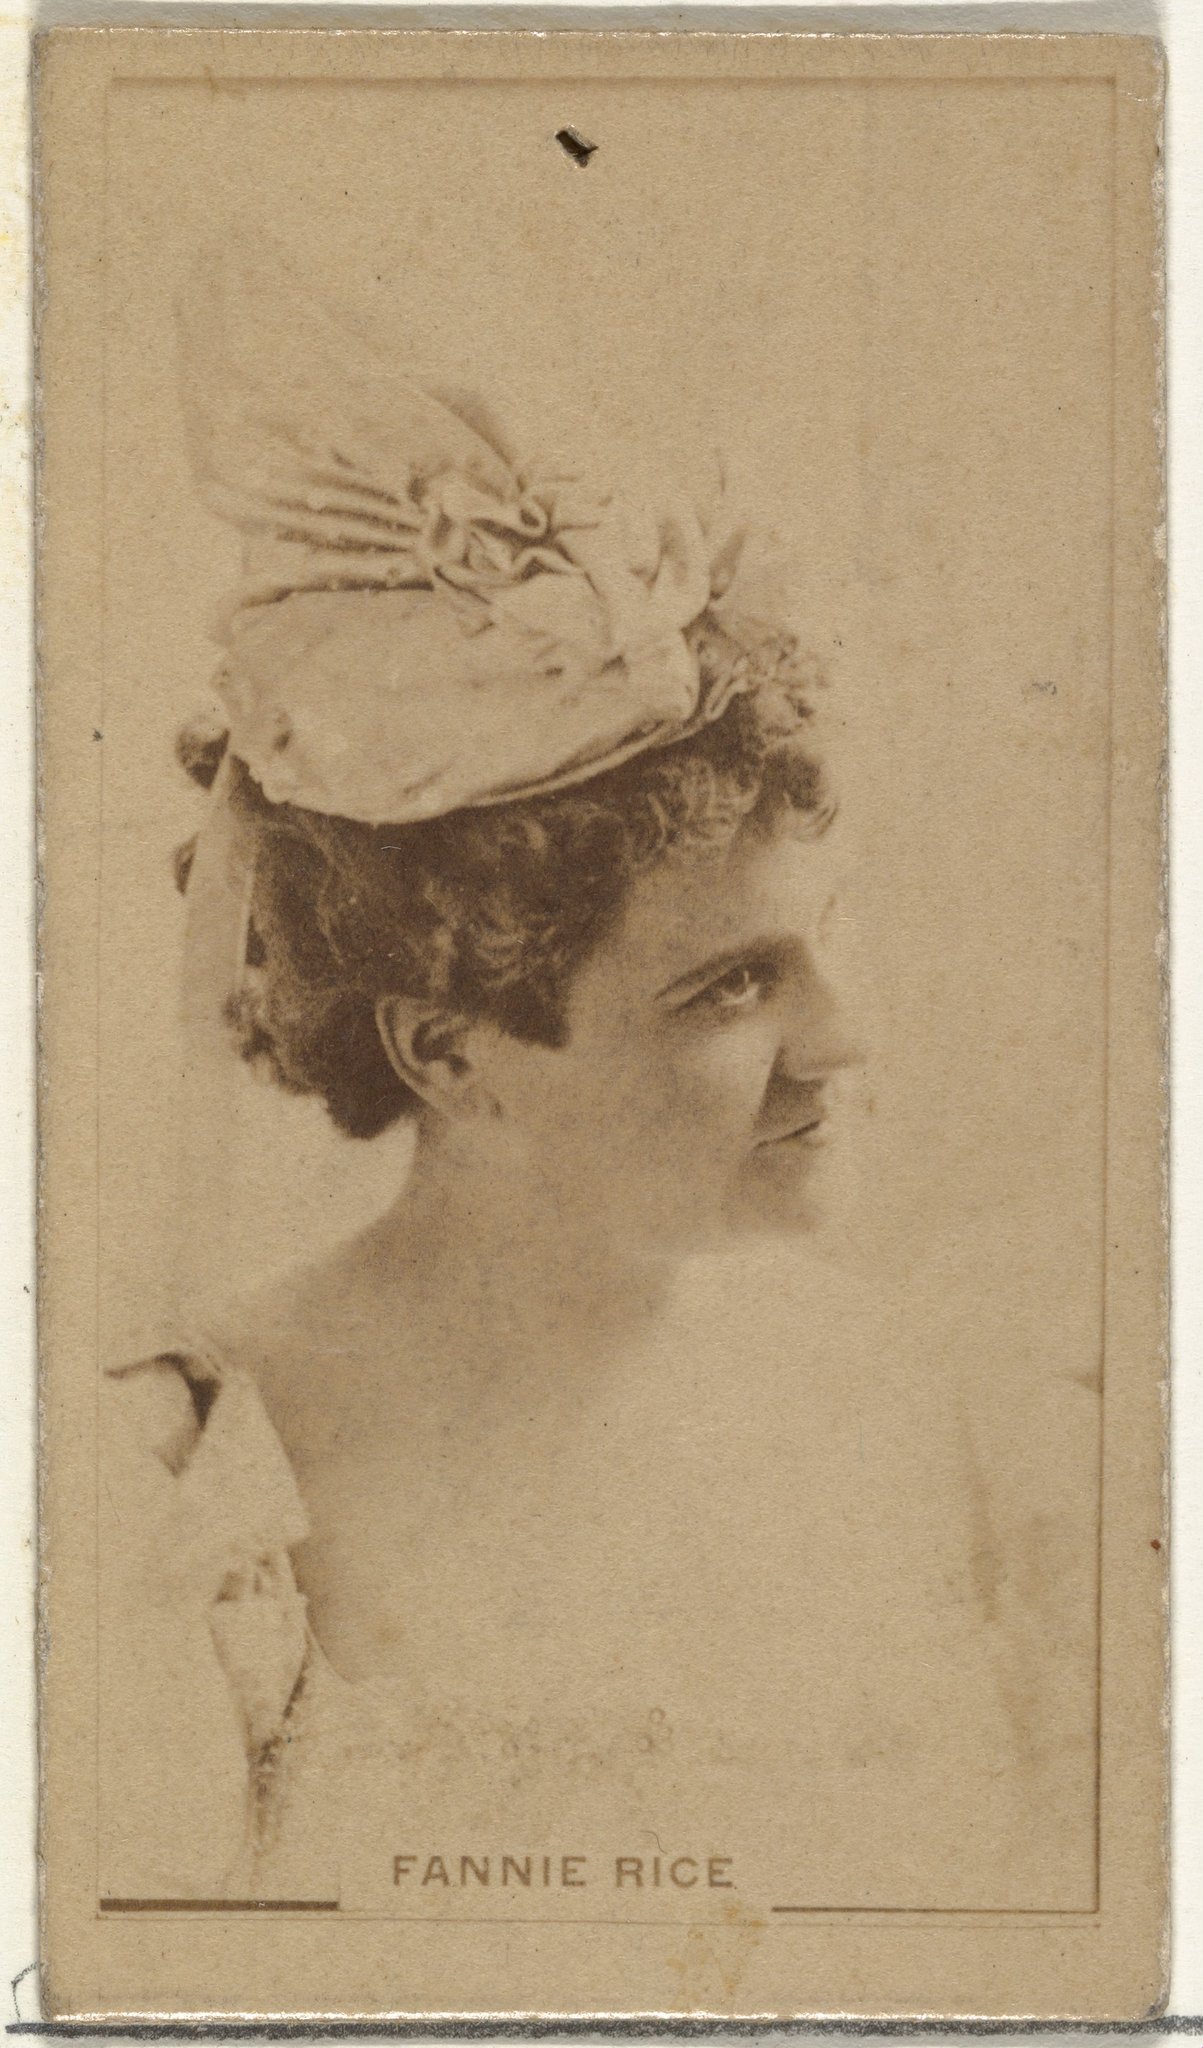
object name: photograph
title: Fannie Rice, from the Actors and Actresses series (N145-8) issued by Duke Sons & Co. to promote Duke Cigarettes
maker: w. duke, sons & co.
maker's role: publisher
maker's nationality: american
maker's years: 1870-1920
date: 1891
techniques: albumen silver print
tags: portraits,women,actresses